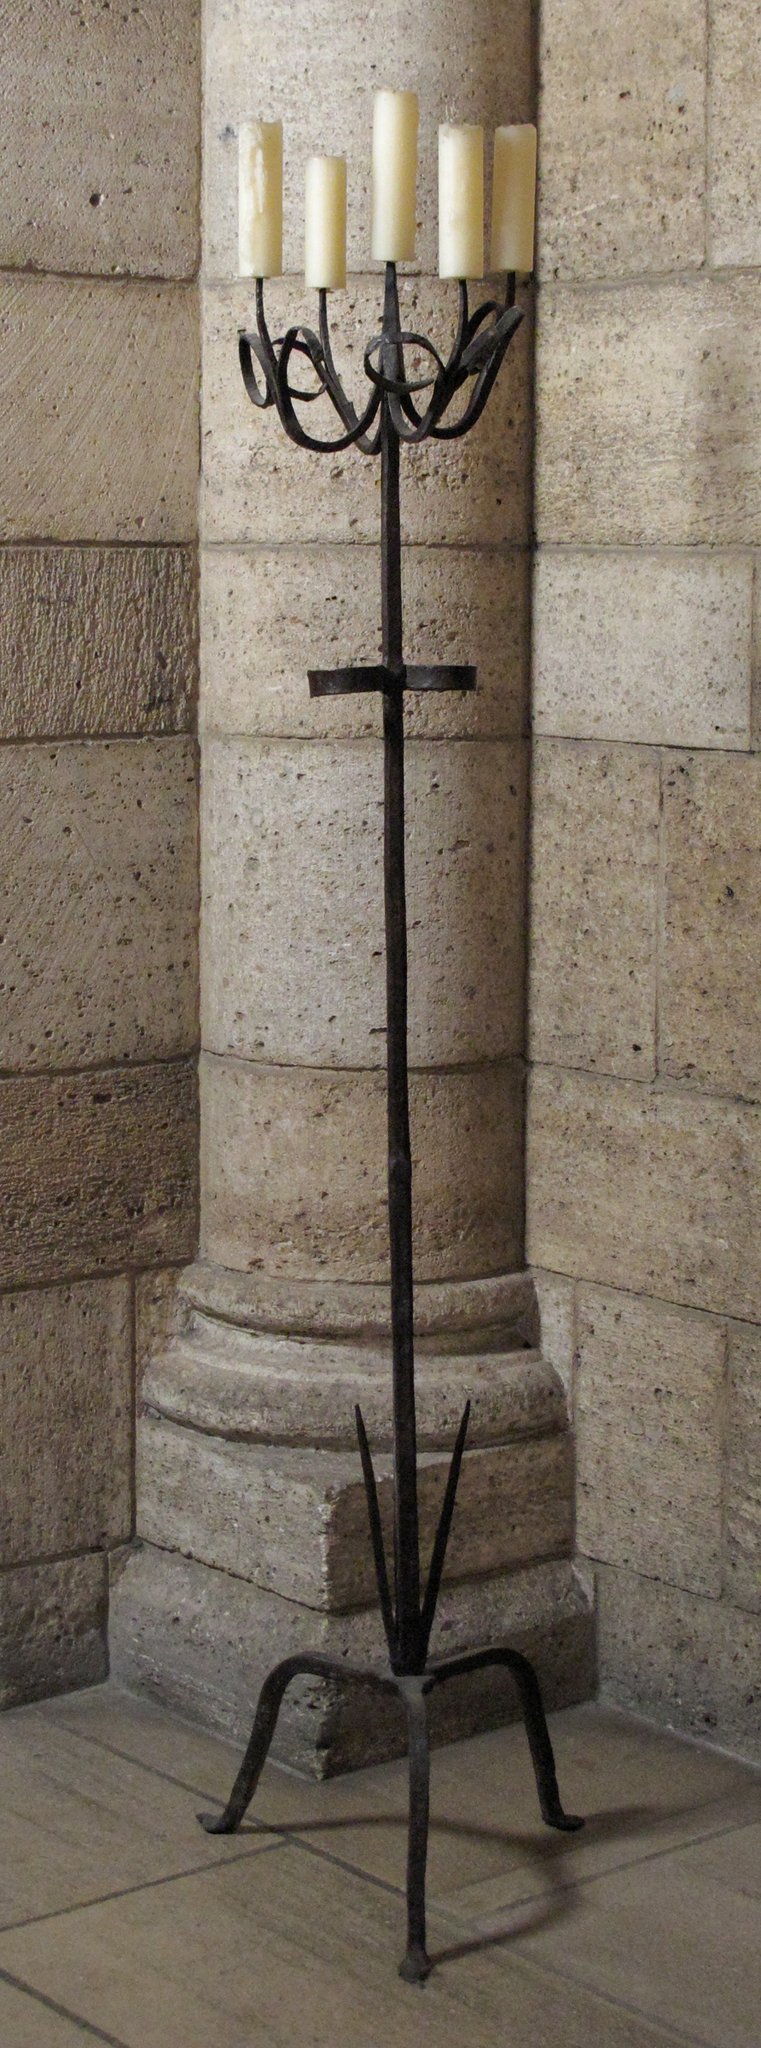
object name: candlestick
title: Pricket Candlestick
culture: european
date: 1401-1500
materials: iron